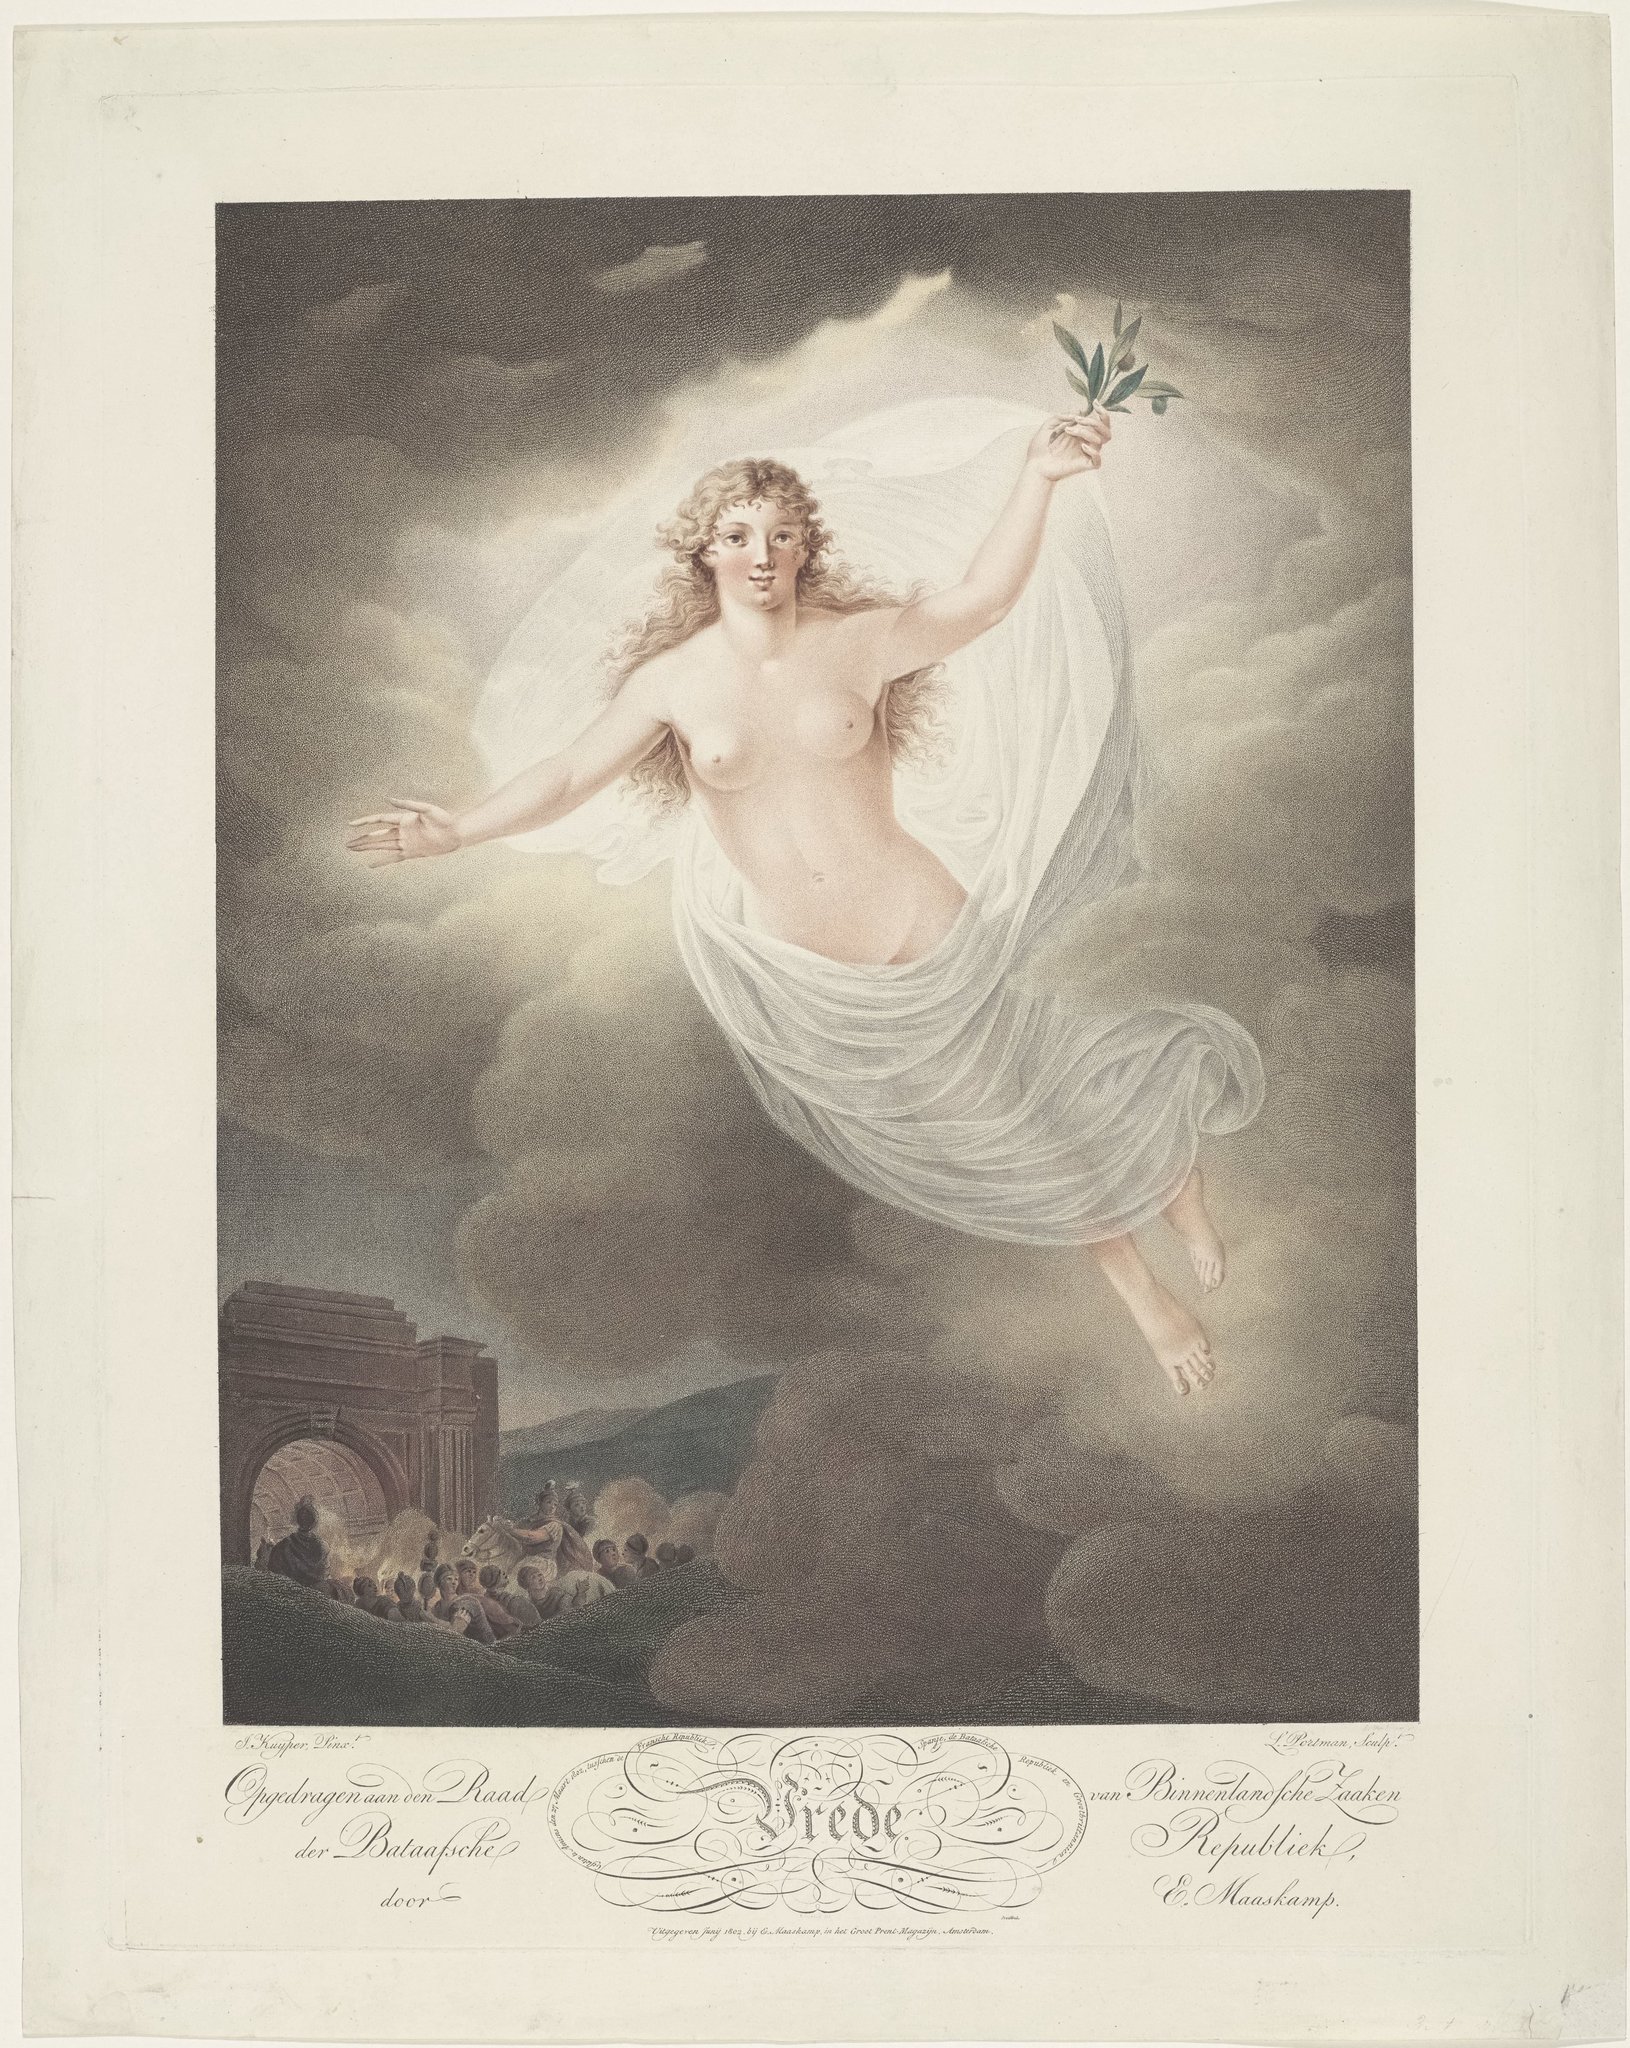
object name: print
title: Allegorie op de Vrede van Amiens, 1802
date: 1802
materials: paper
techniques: printing, engraving, hand coloring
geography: netherlands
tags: symbols, allegories of peace, 'pax'; 'pace' (ripa), conqueror triumphing, triumphal entry of victor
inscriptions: collector's mark: Lugt 2228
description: Allegorie op de Vrede van Amiens, op 27 maart 1802, die een einde maakte aan de oorlog tussen Groot-Brittannië en de Franse republiek, Spanje en de Bataafse Republiek. Centraal zweeft de Vrede door de wolken met een olijftak in de hand. Linksonder keert het afgematte leger terug binnen de vesting.